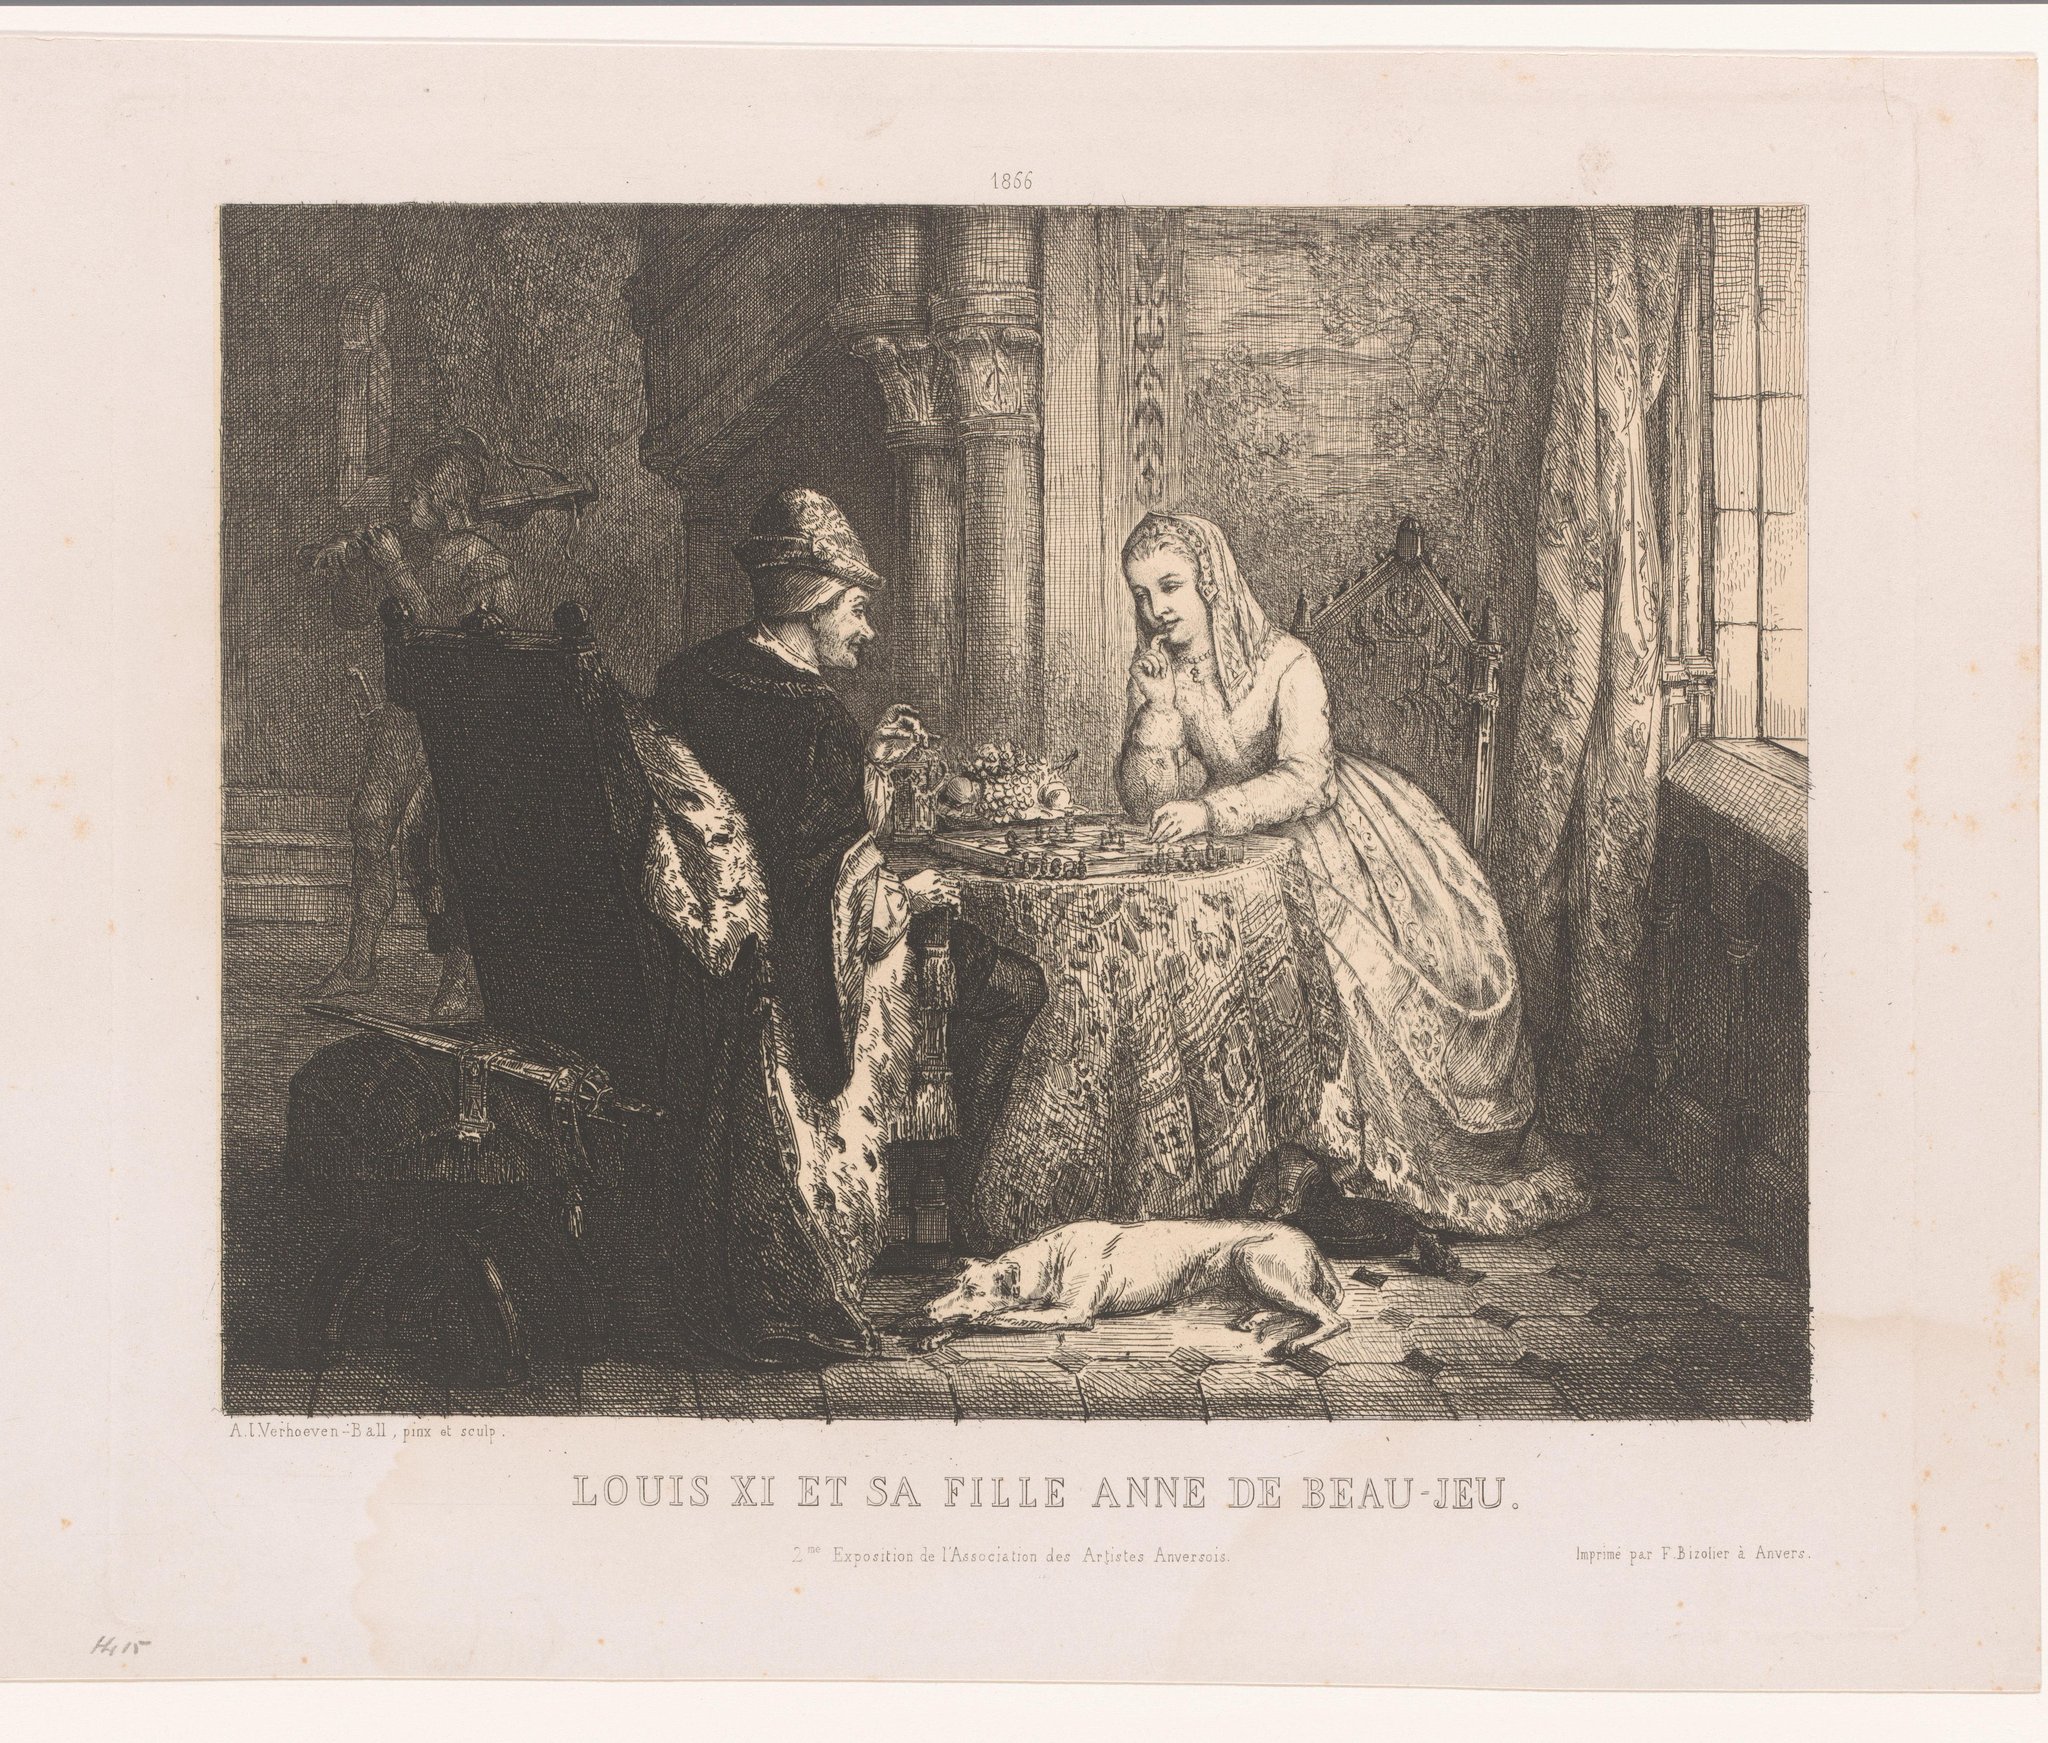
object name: print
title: Louis XI et sa fille Anne de Beau-Jeu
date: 1866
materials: paper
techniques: drypoint, etching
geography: antwerp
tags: genappe, chess, historical persons, king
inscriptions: collector's mark: Lugt 2228